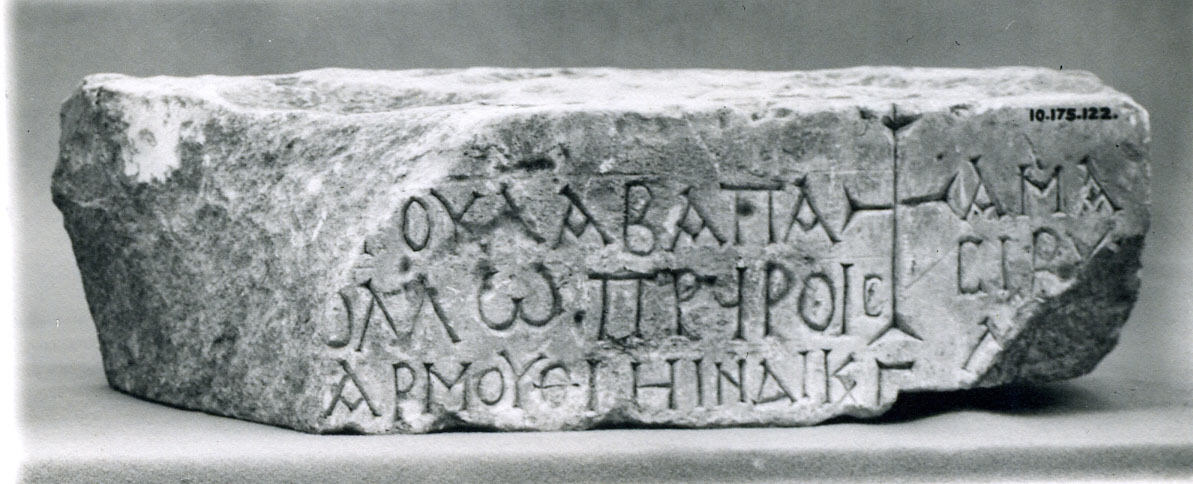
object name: fragment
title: Fragment of an Inscribed Block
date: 501-700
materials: limestone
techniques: incising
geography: egypt